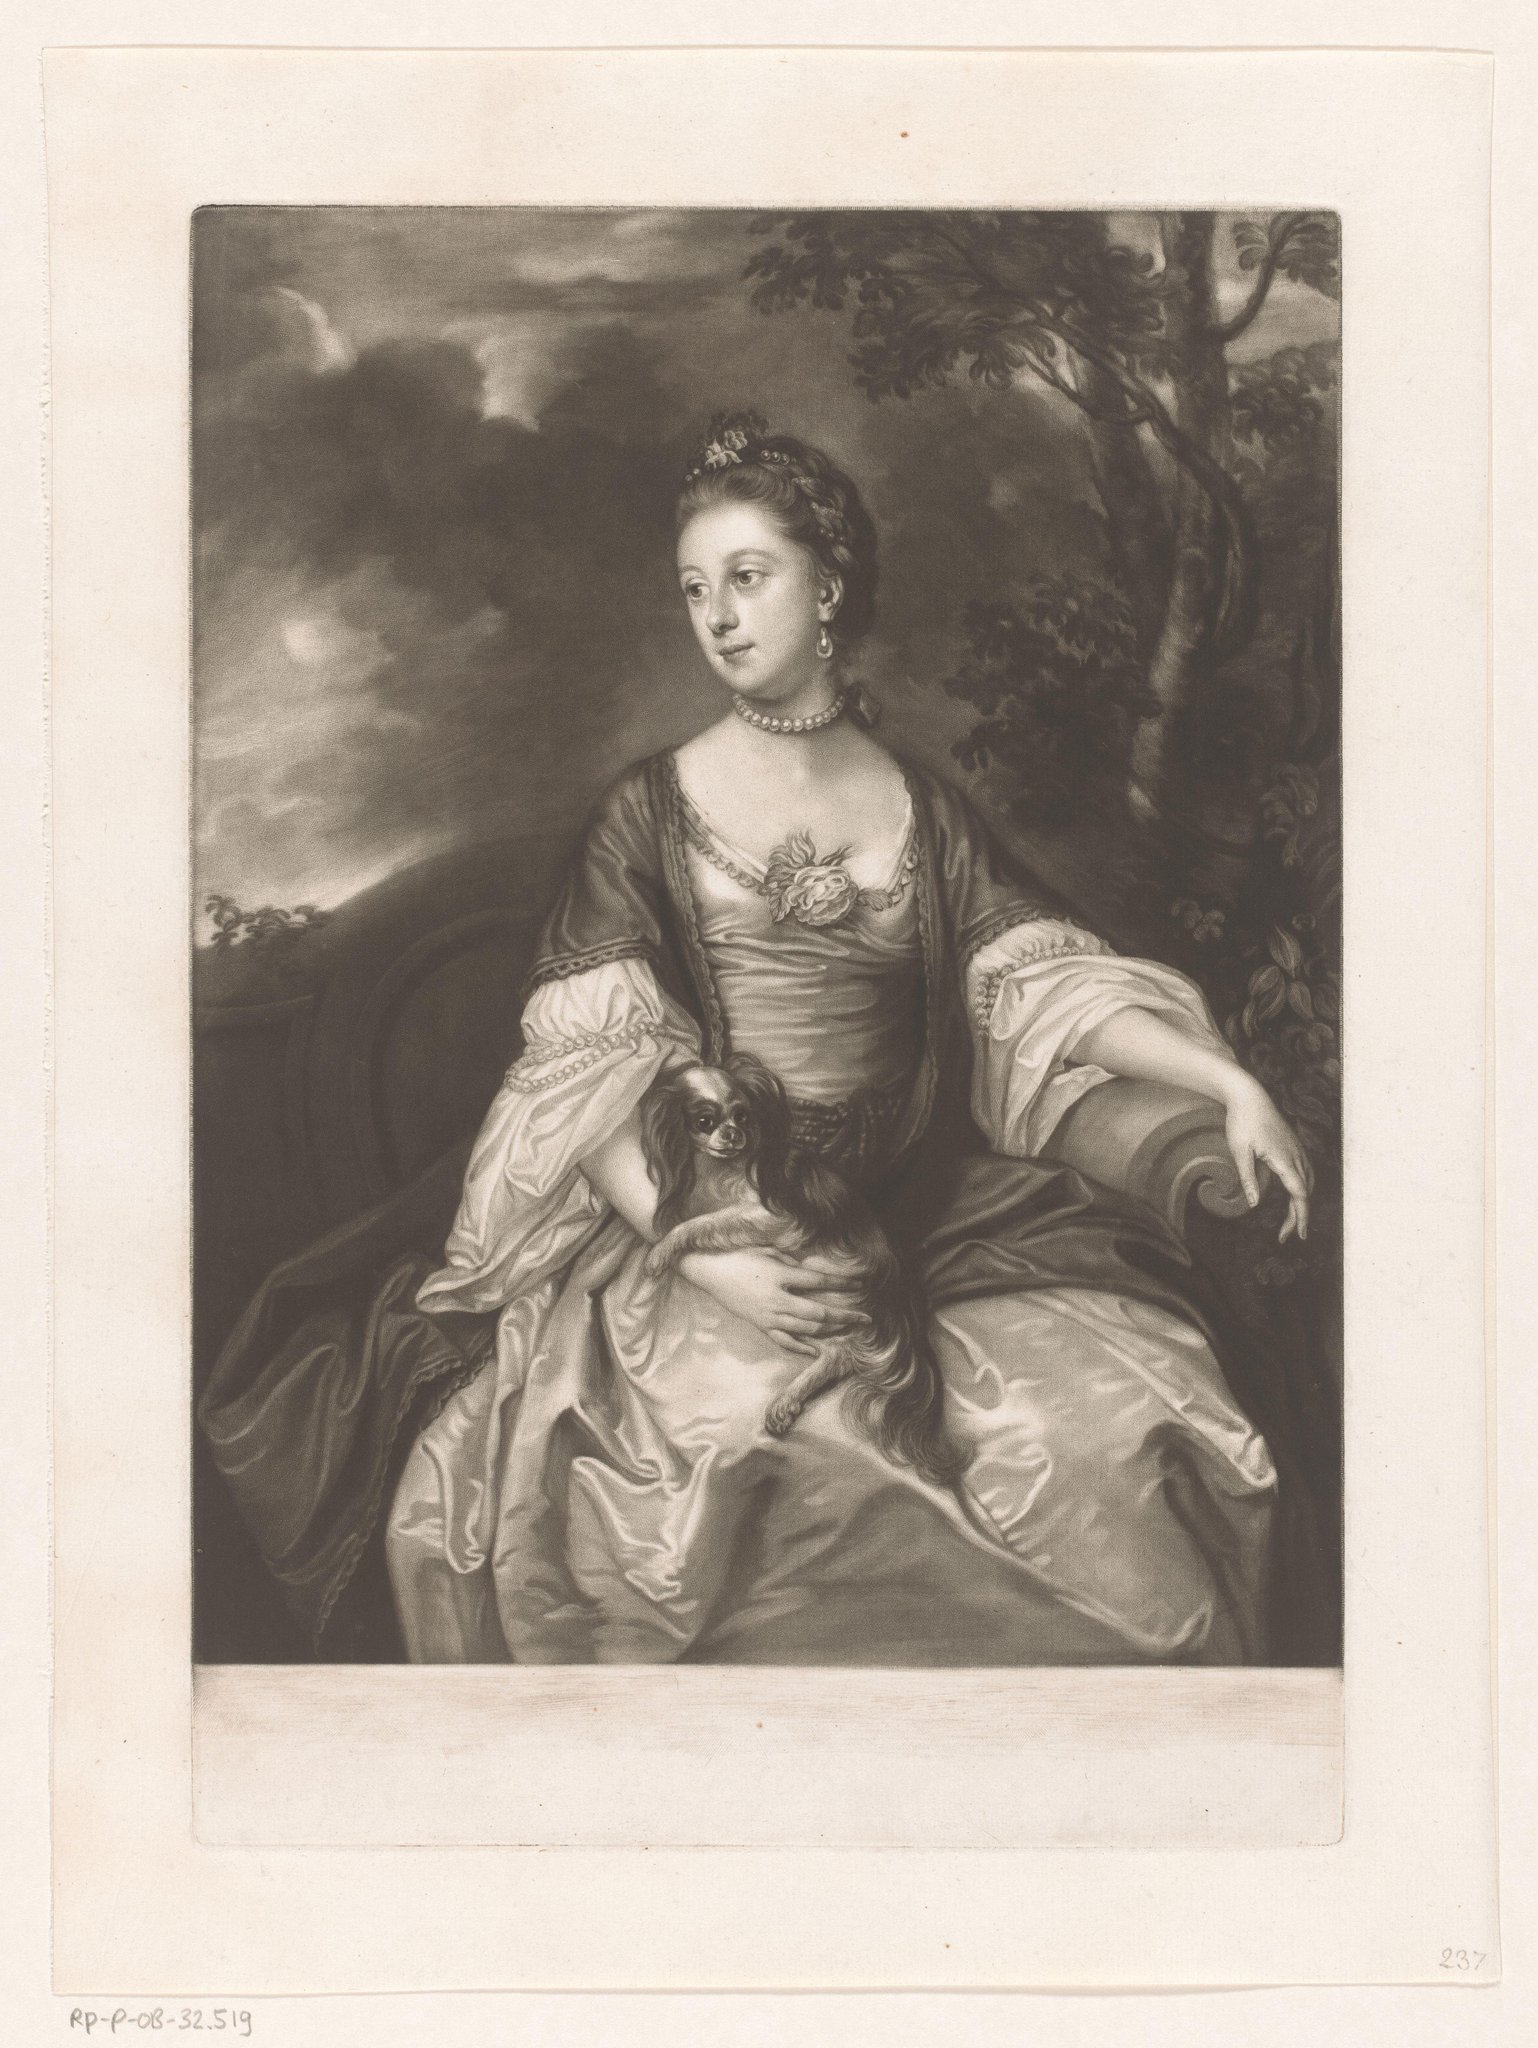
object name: print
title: Portret van Caroline Spencer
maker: james mcardell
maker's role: print maker, publisher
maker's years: 1728-1765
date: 1759-1762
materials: paper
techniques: mezzotint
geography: london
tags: historical persons - bb - woman, dog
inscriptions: collector's mark: Lugt 240